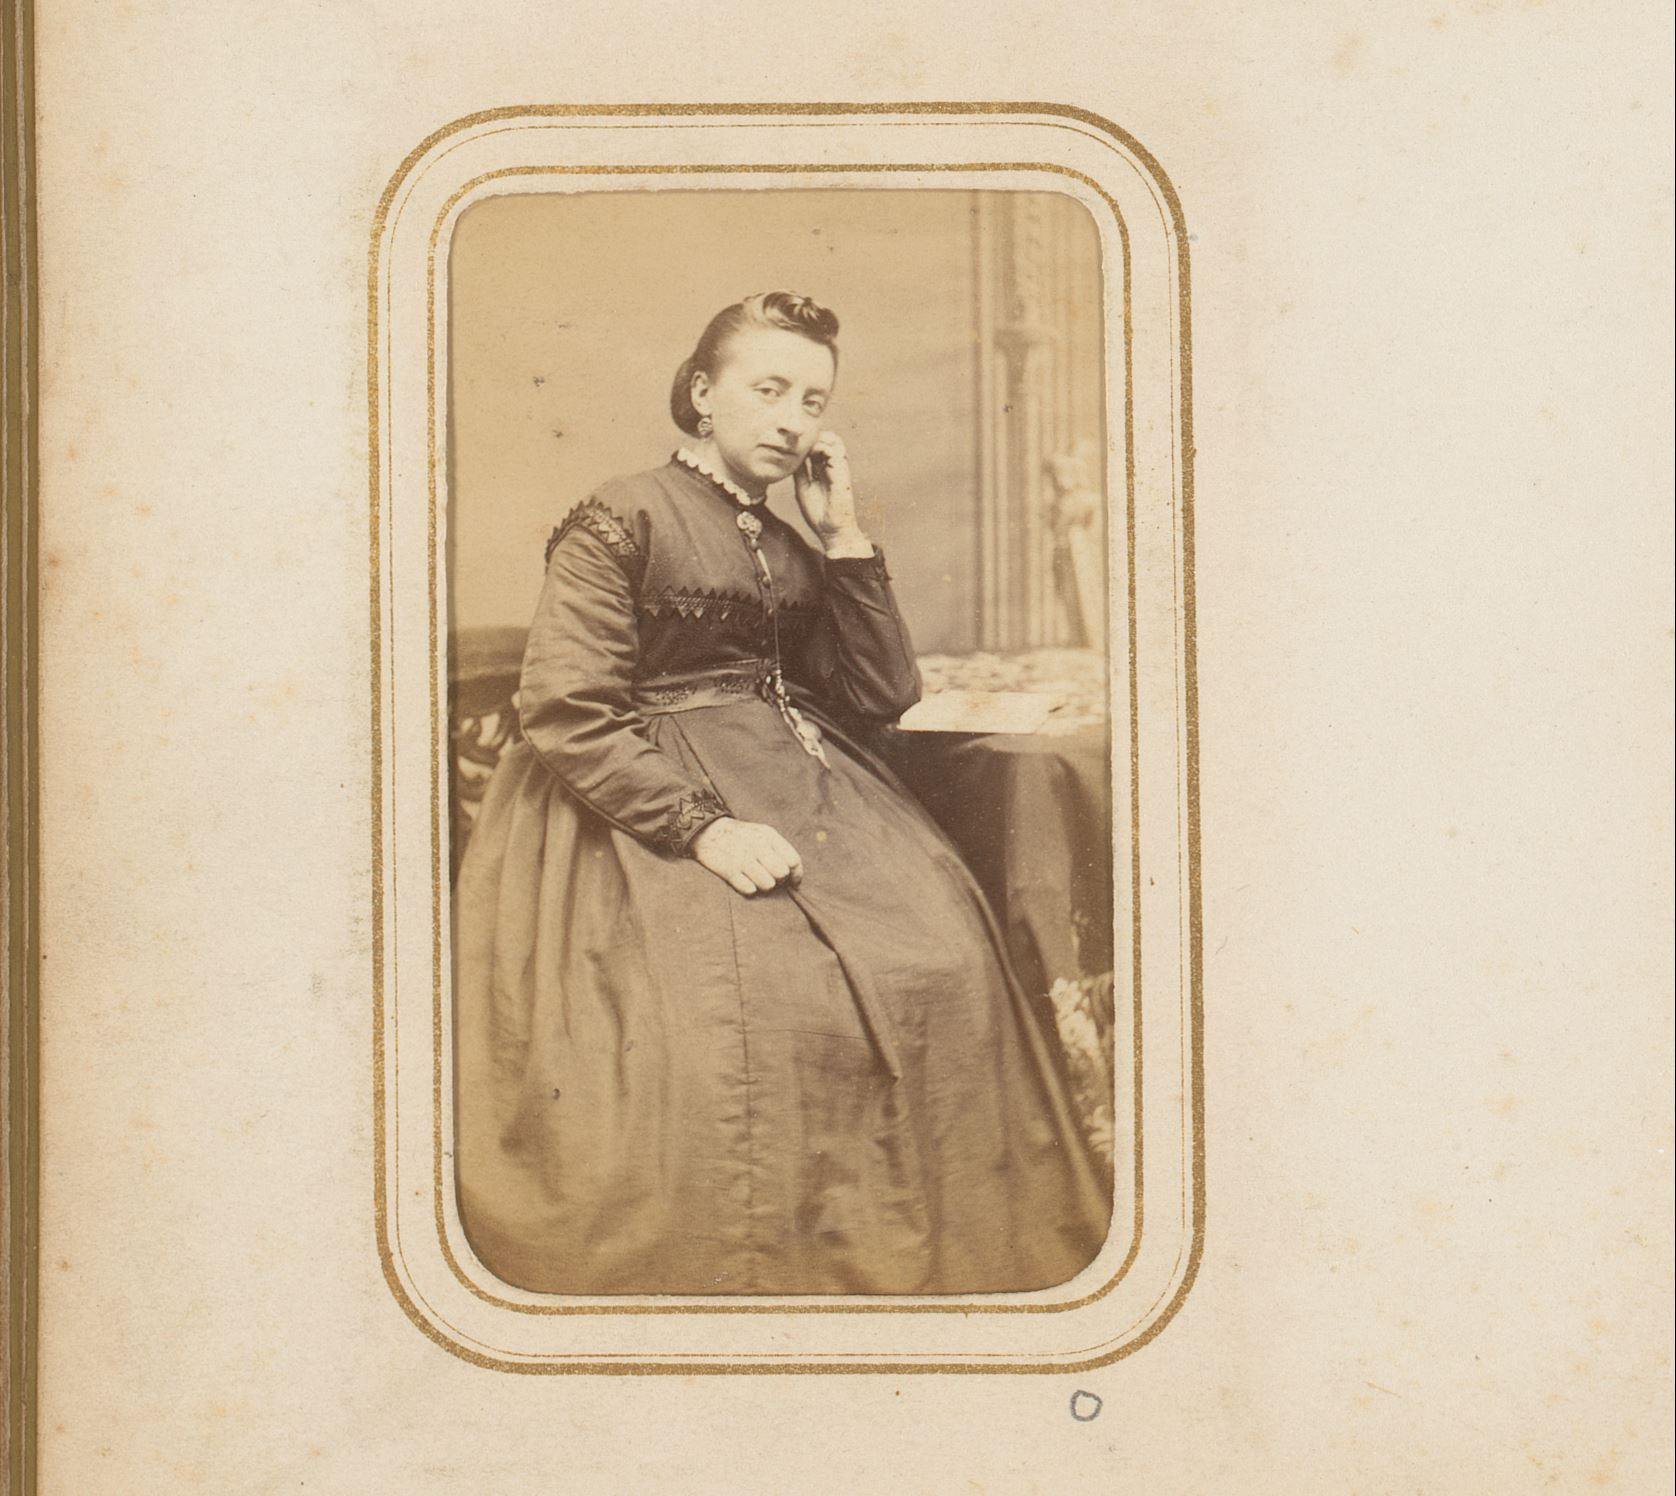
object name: photograph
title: Portret van een zittende vrouw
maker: Anonymous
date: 1850-1880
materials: cardboard, photographic support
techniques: albumen print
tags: historical persons - bb - woman